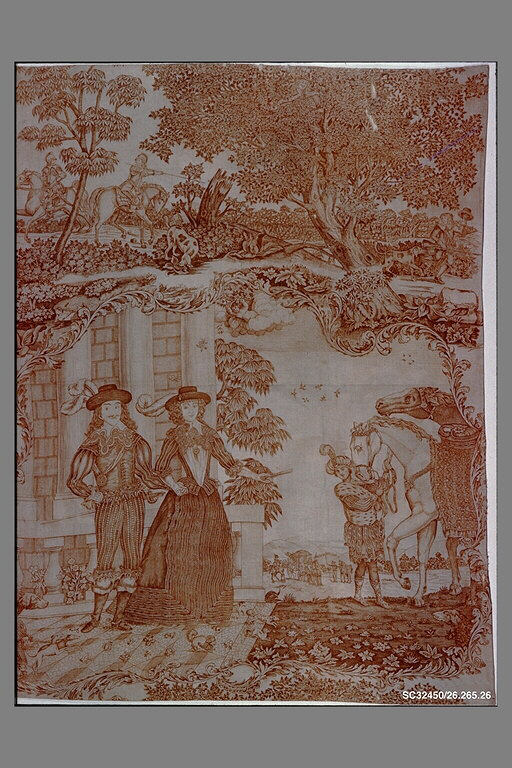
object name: piece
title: Copper plate printed cotton with King Charles I and Queen Henrietta Maria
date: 1785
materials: cotton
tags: kings,queens,horses,trees